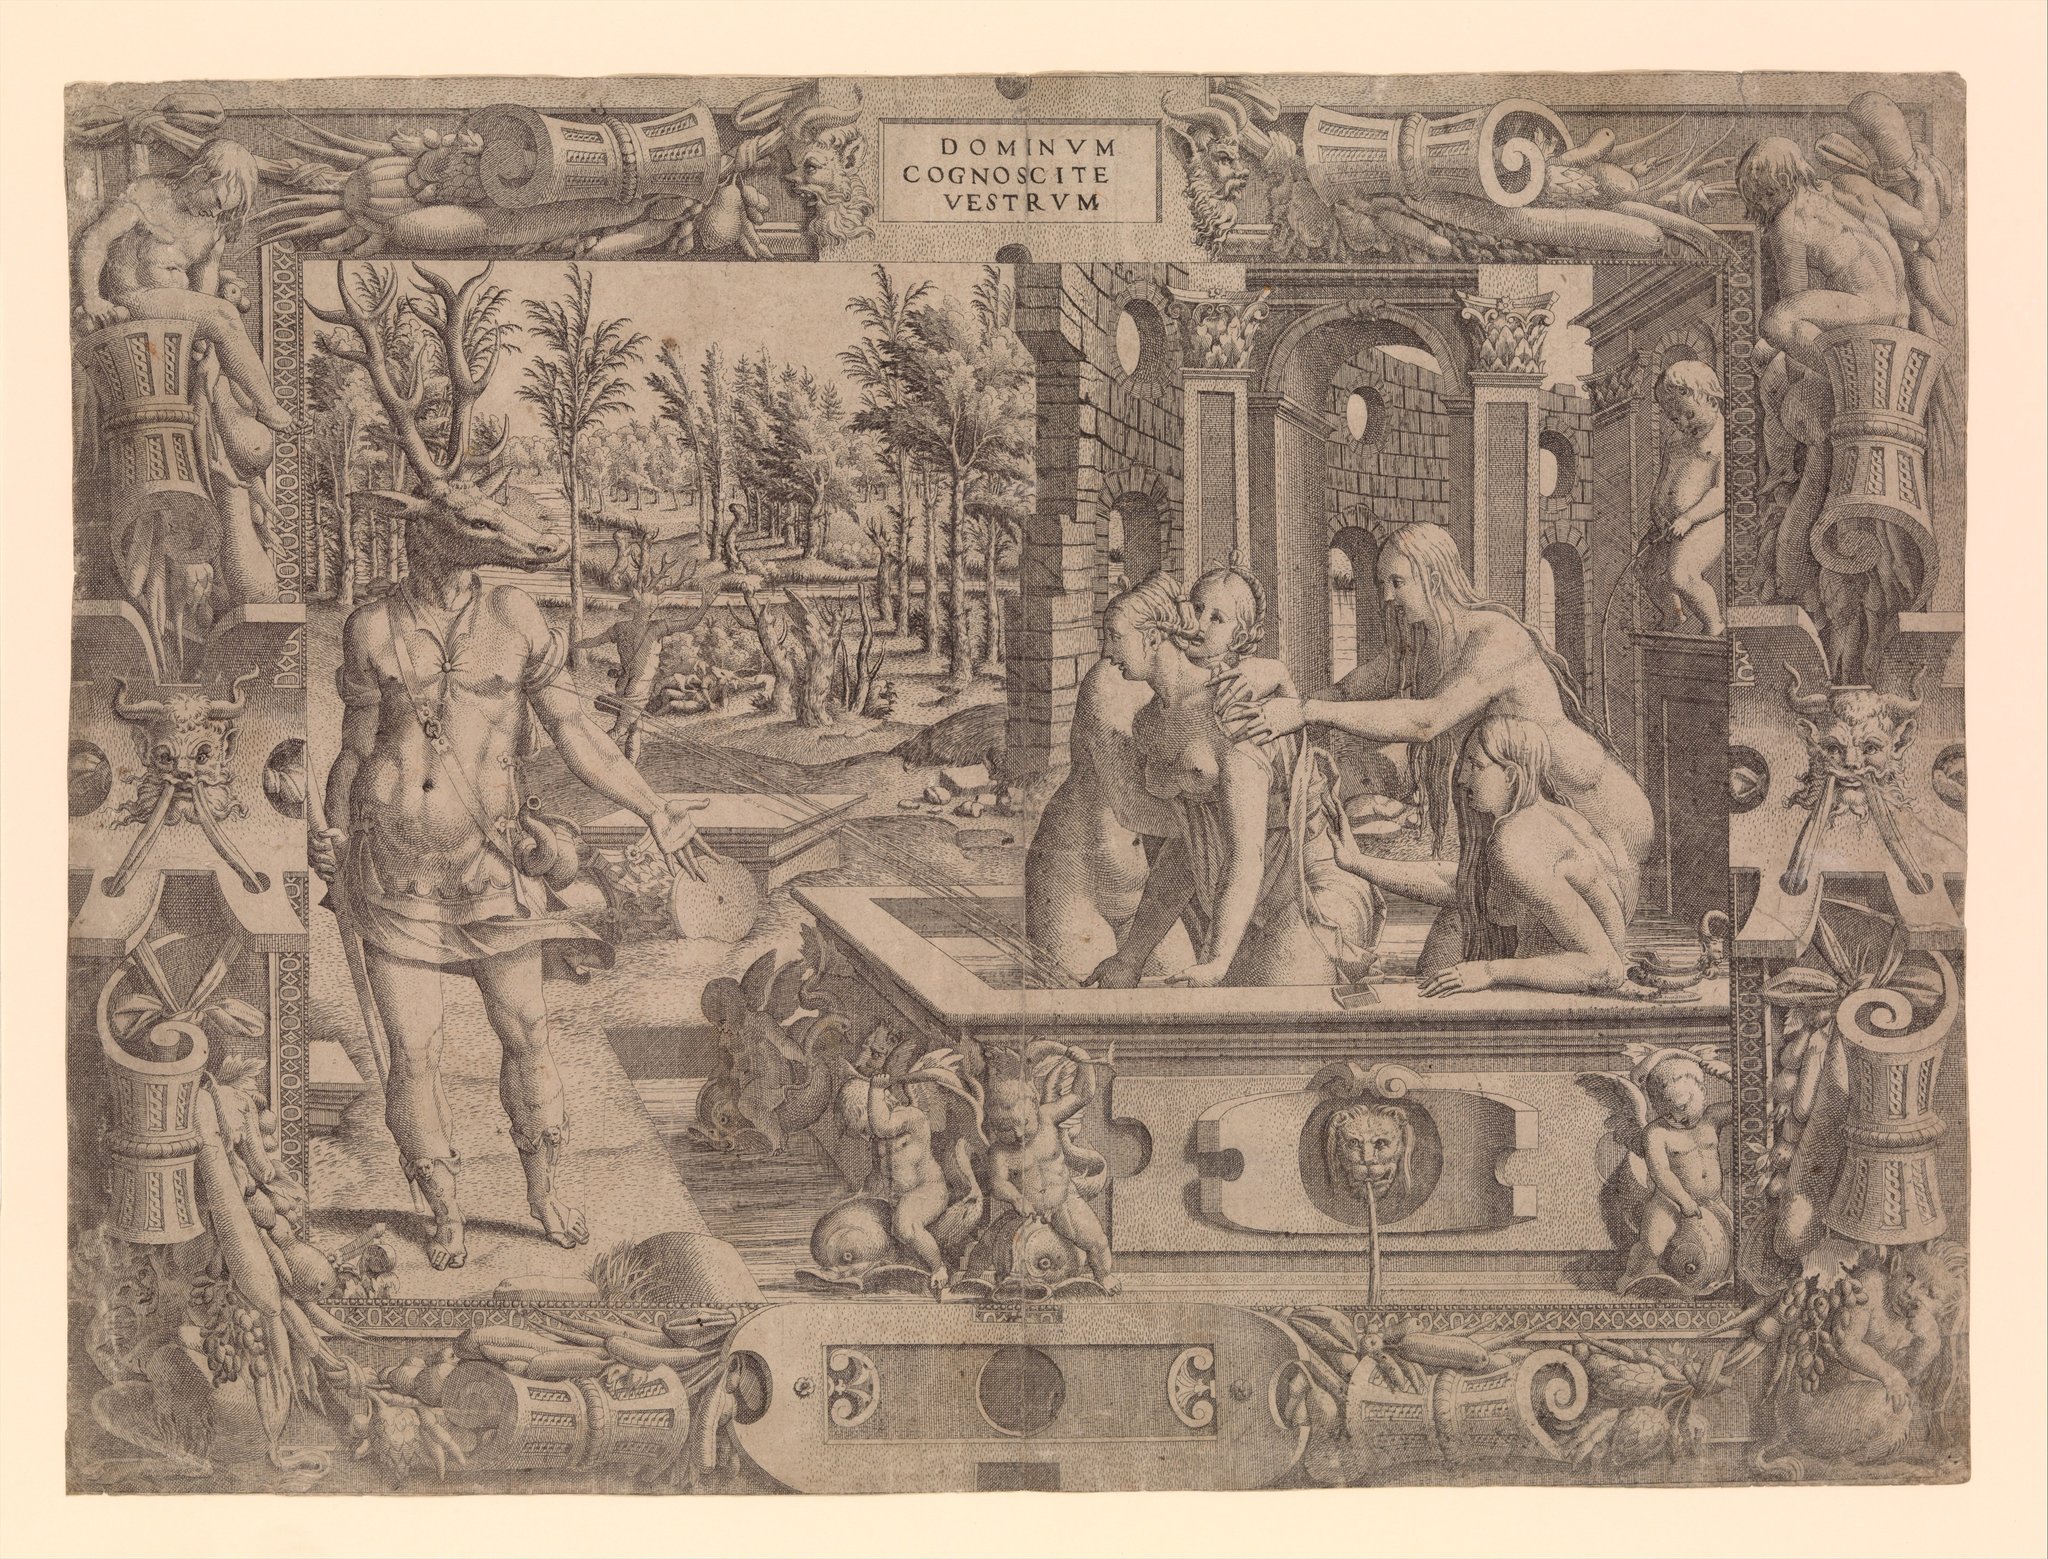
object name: print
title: The Metamorphosis of Actaeon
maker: jean mignon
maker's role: artist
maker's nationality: french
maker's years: 1535-1555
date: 1535-1555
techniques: etching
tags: female nudes,cupid,diana,trees